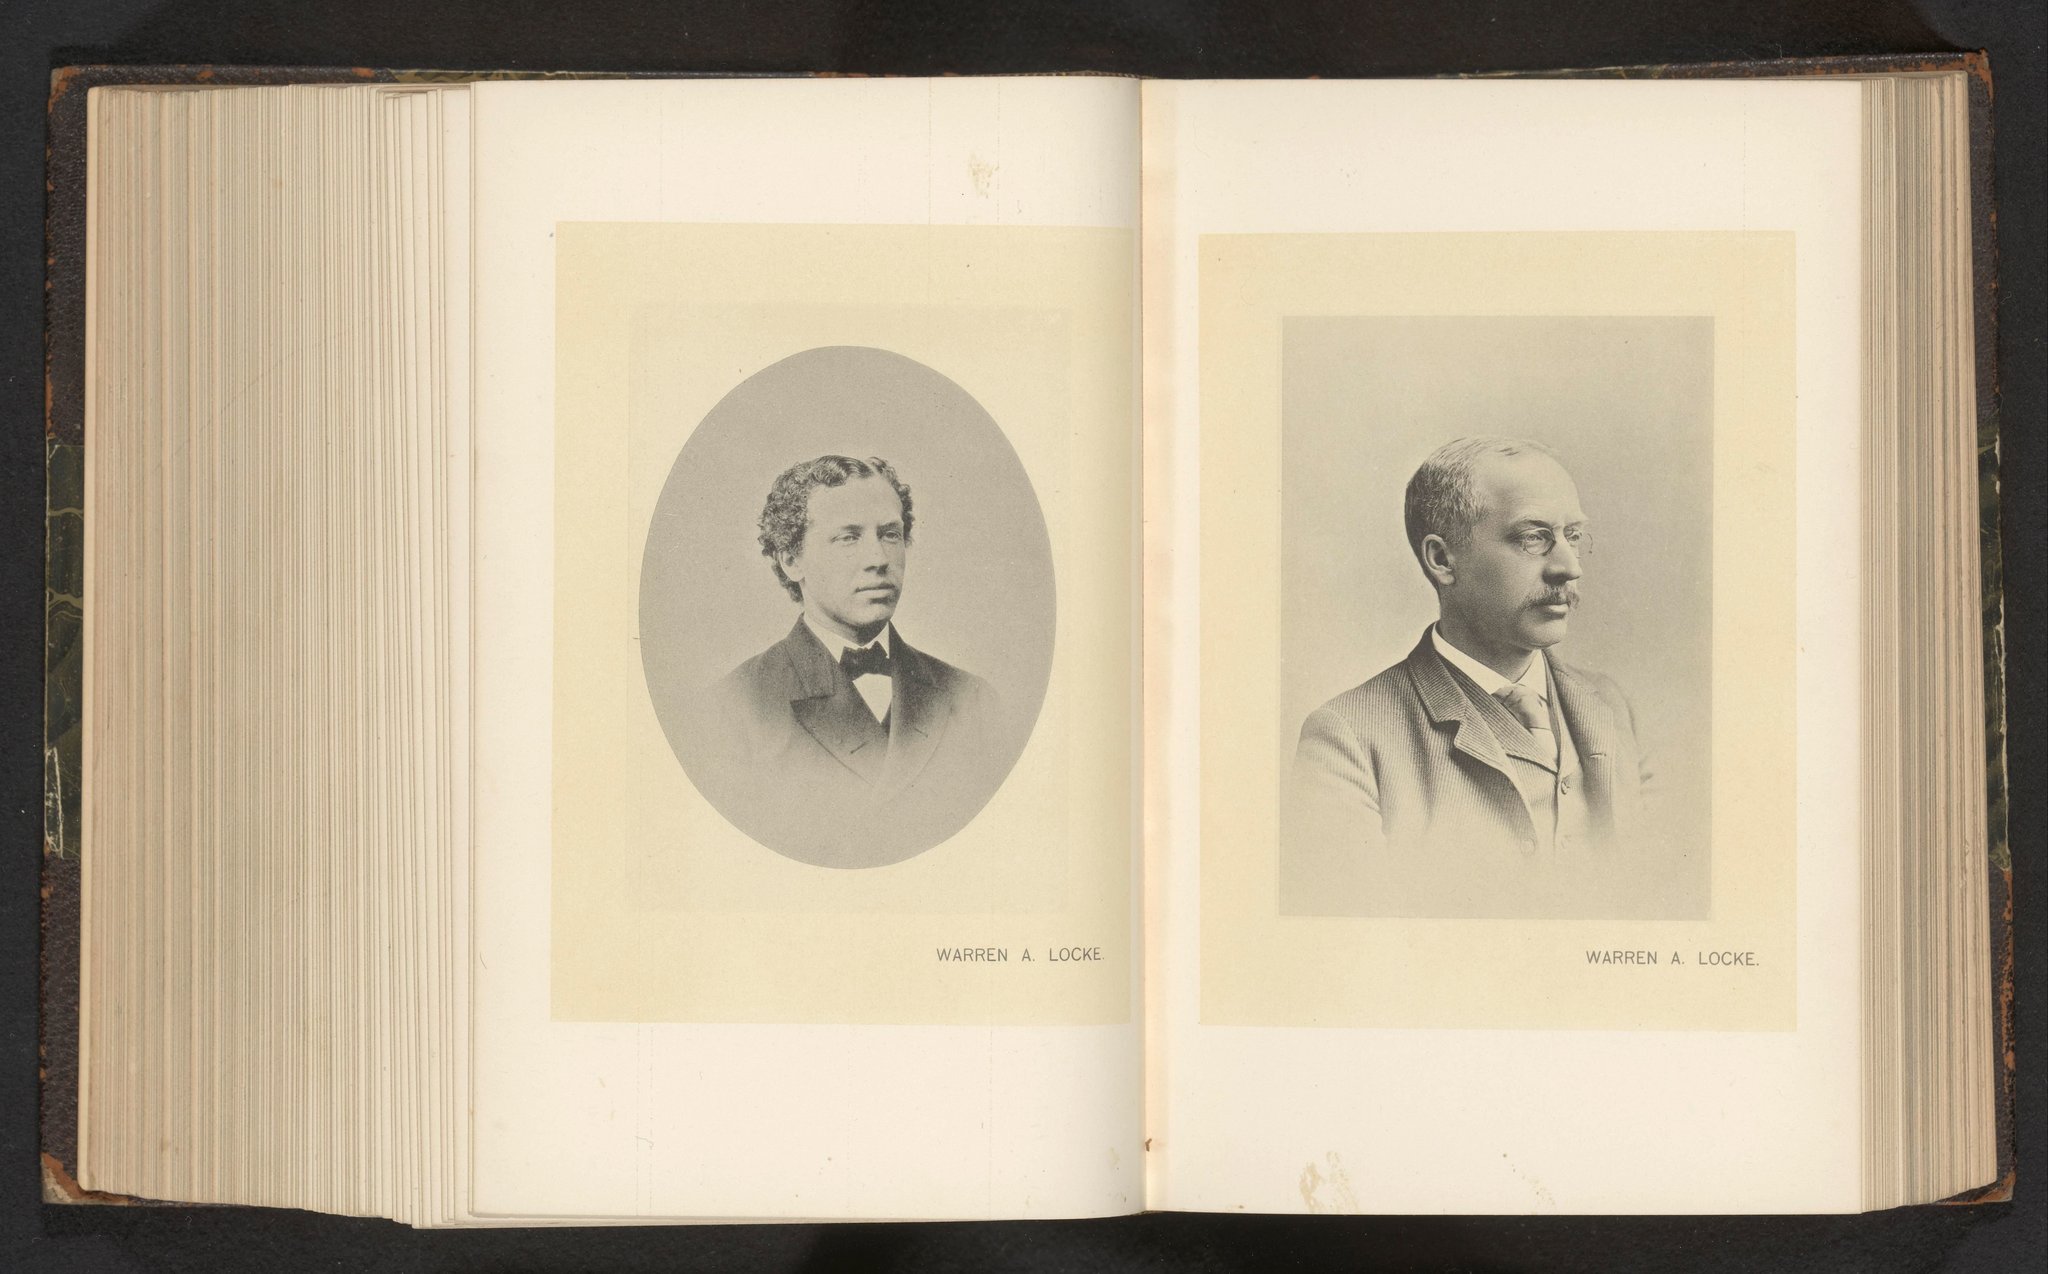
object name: page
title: Warren A. Locke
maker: Anonymous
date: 1889-1894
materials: paper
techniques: photoaquatint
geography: boston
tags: adult man